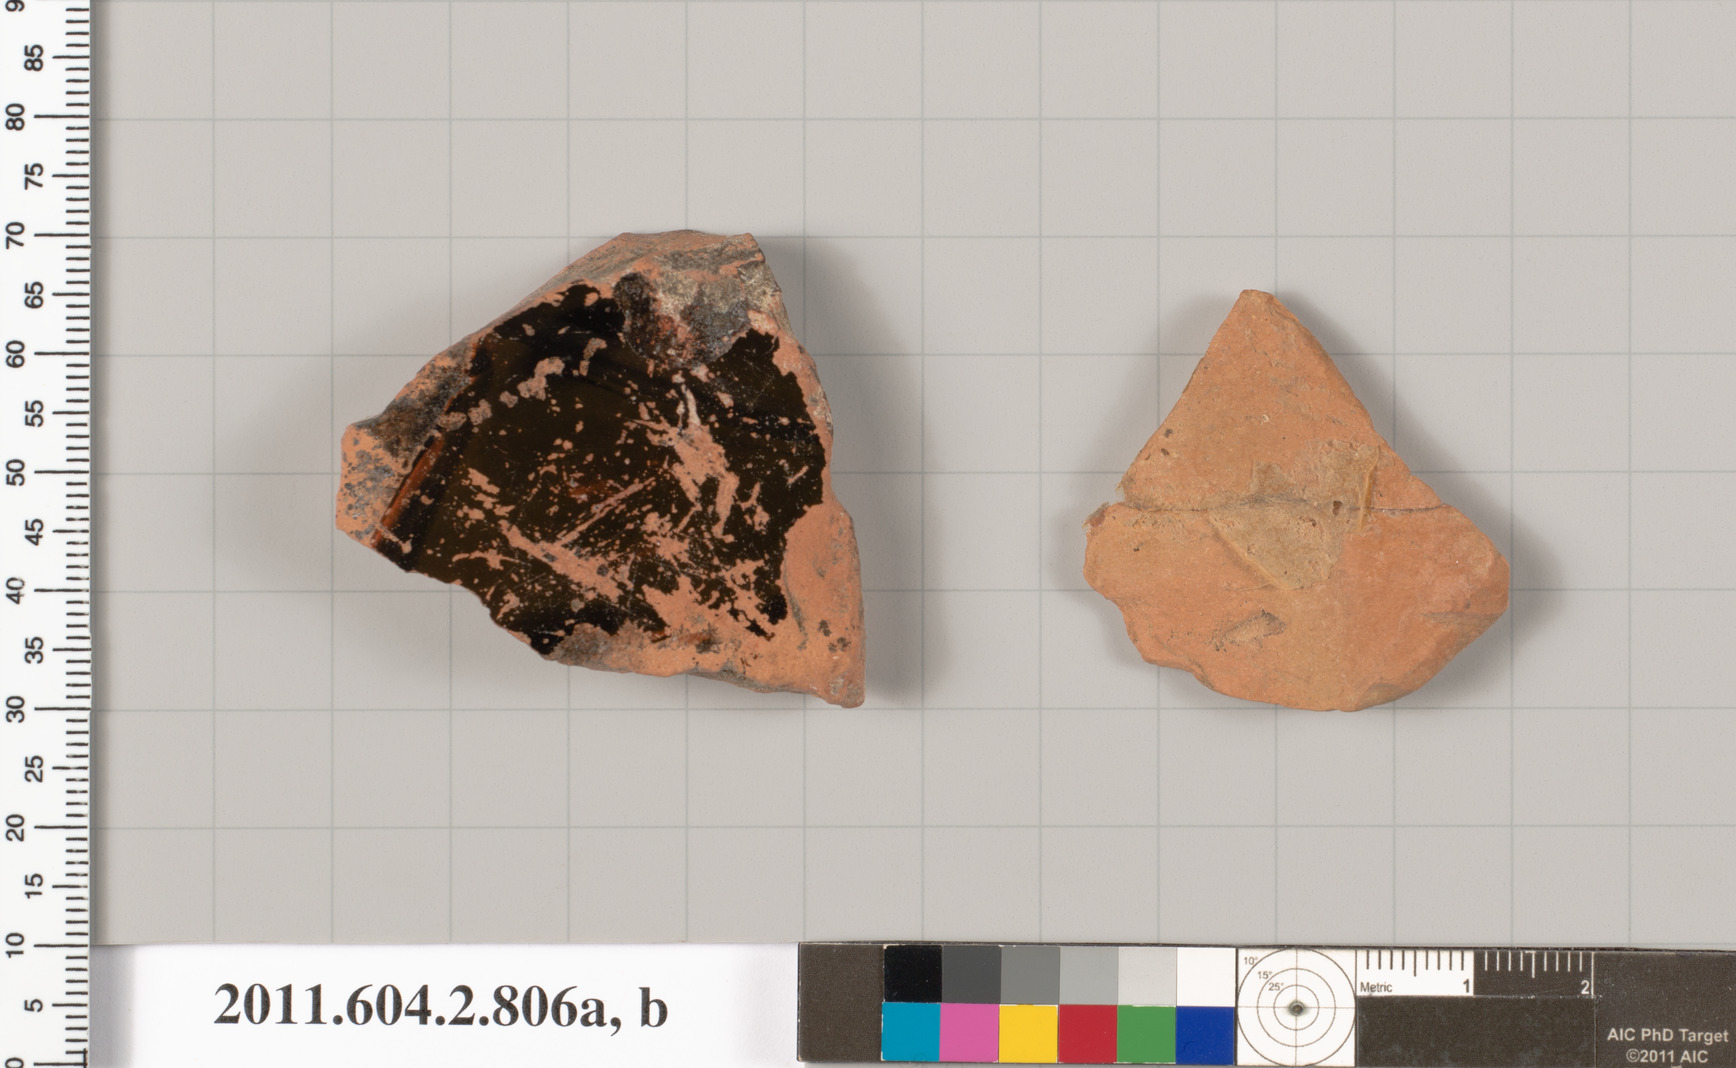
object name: calyx krater fragment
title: Terracotta fragments of calyx-kraters (bowls for mixing wine and water)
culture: greek, attic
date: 600-401 BCE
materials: terracotta